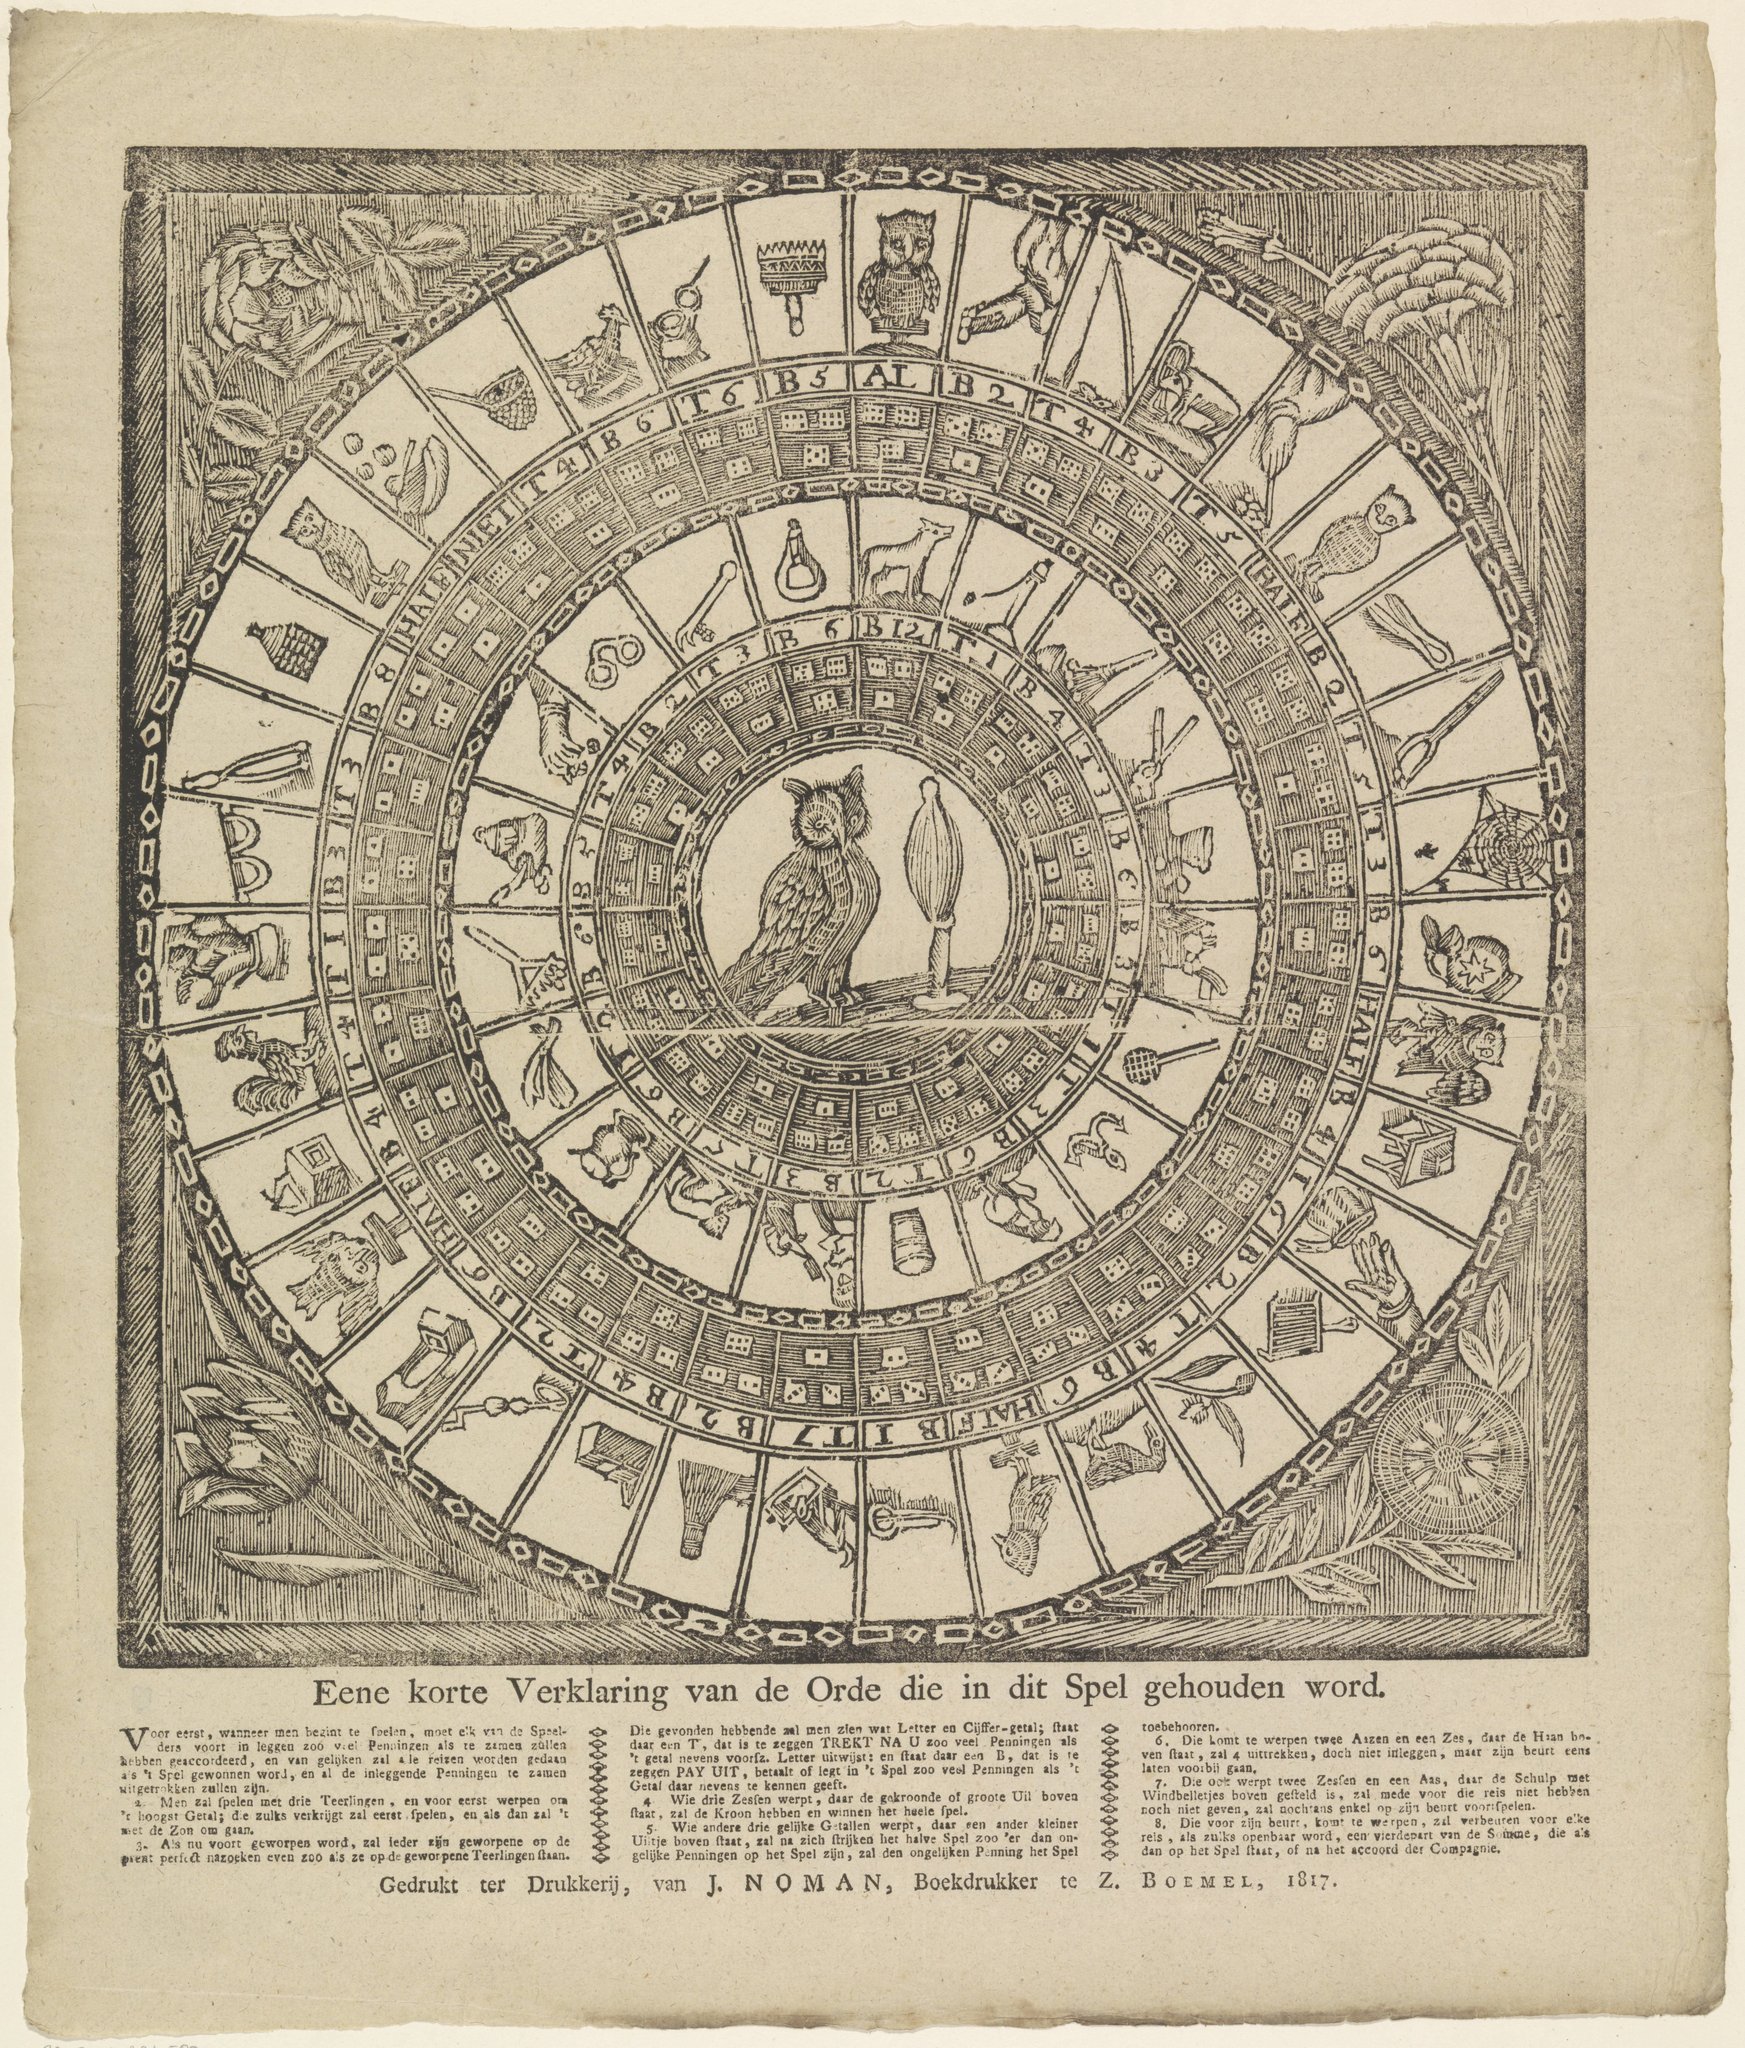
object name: print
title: Uilenspel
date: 1817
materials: paper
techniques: letterpress printing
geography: zaltbommel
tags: board-games of chance, owls, board-games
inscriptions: collector's mark: Lugt 2760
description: Het Uilenspel. Een cirkelvormig bordspel met vakjes met daarin voorwerpen, dieren en dobbelstenen. In het midden een uil met een spiegel. Onder de voorstelling de spelregels in drie kolommen. Bloemen in de hoeken.